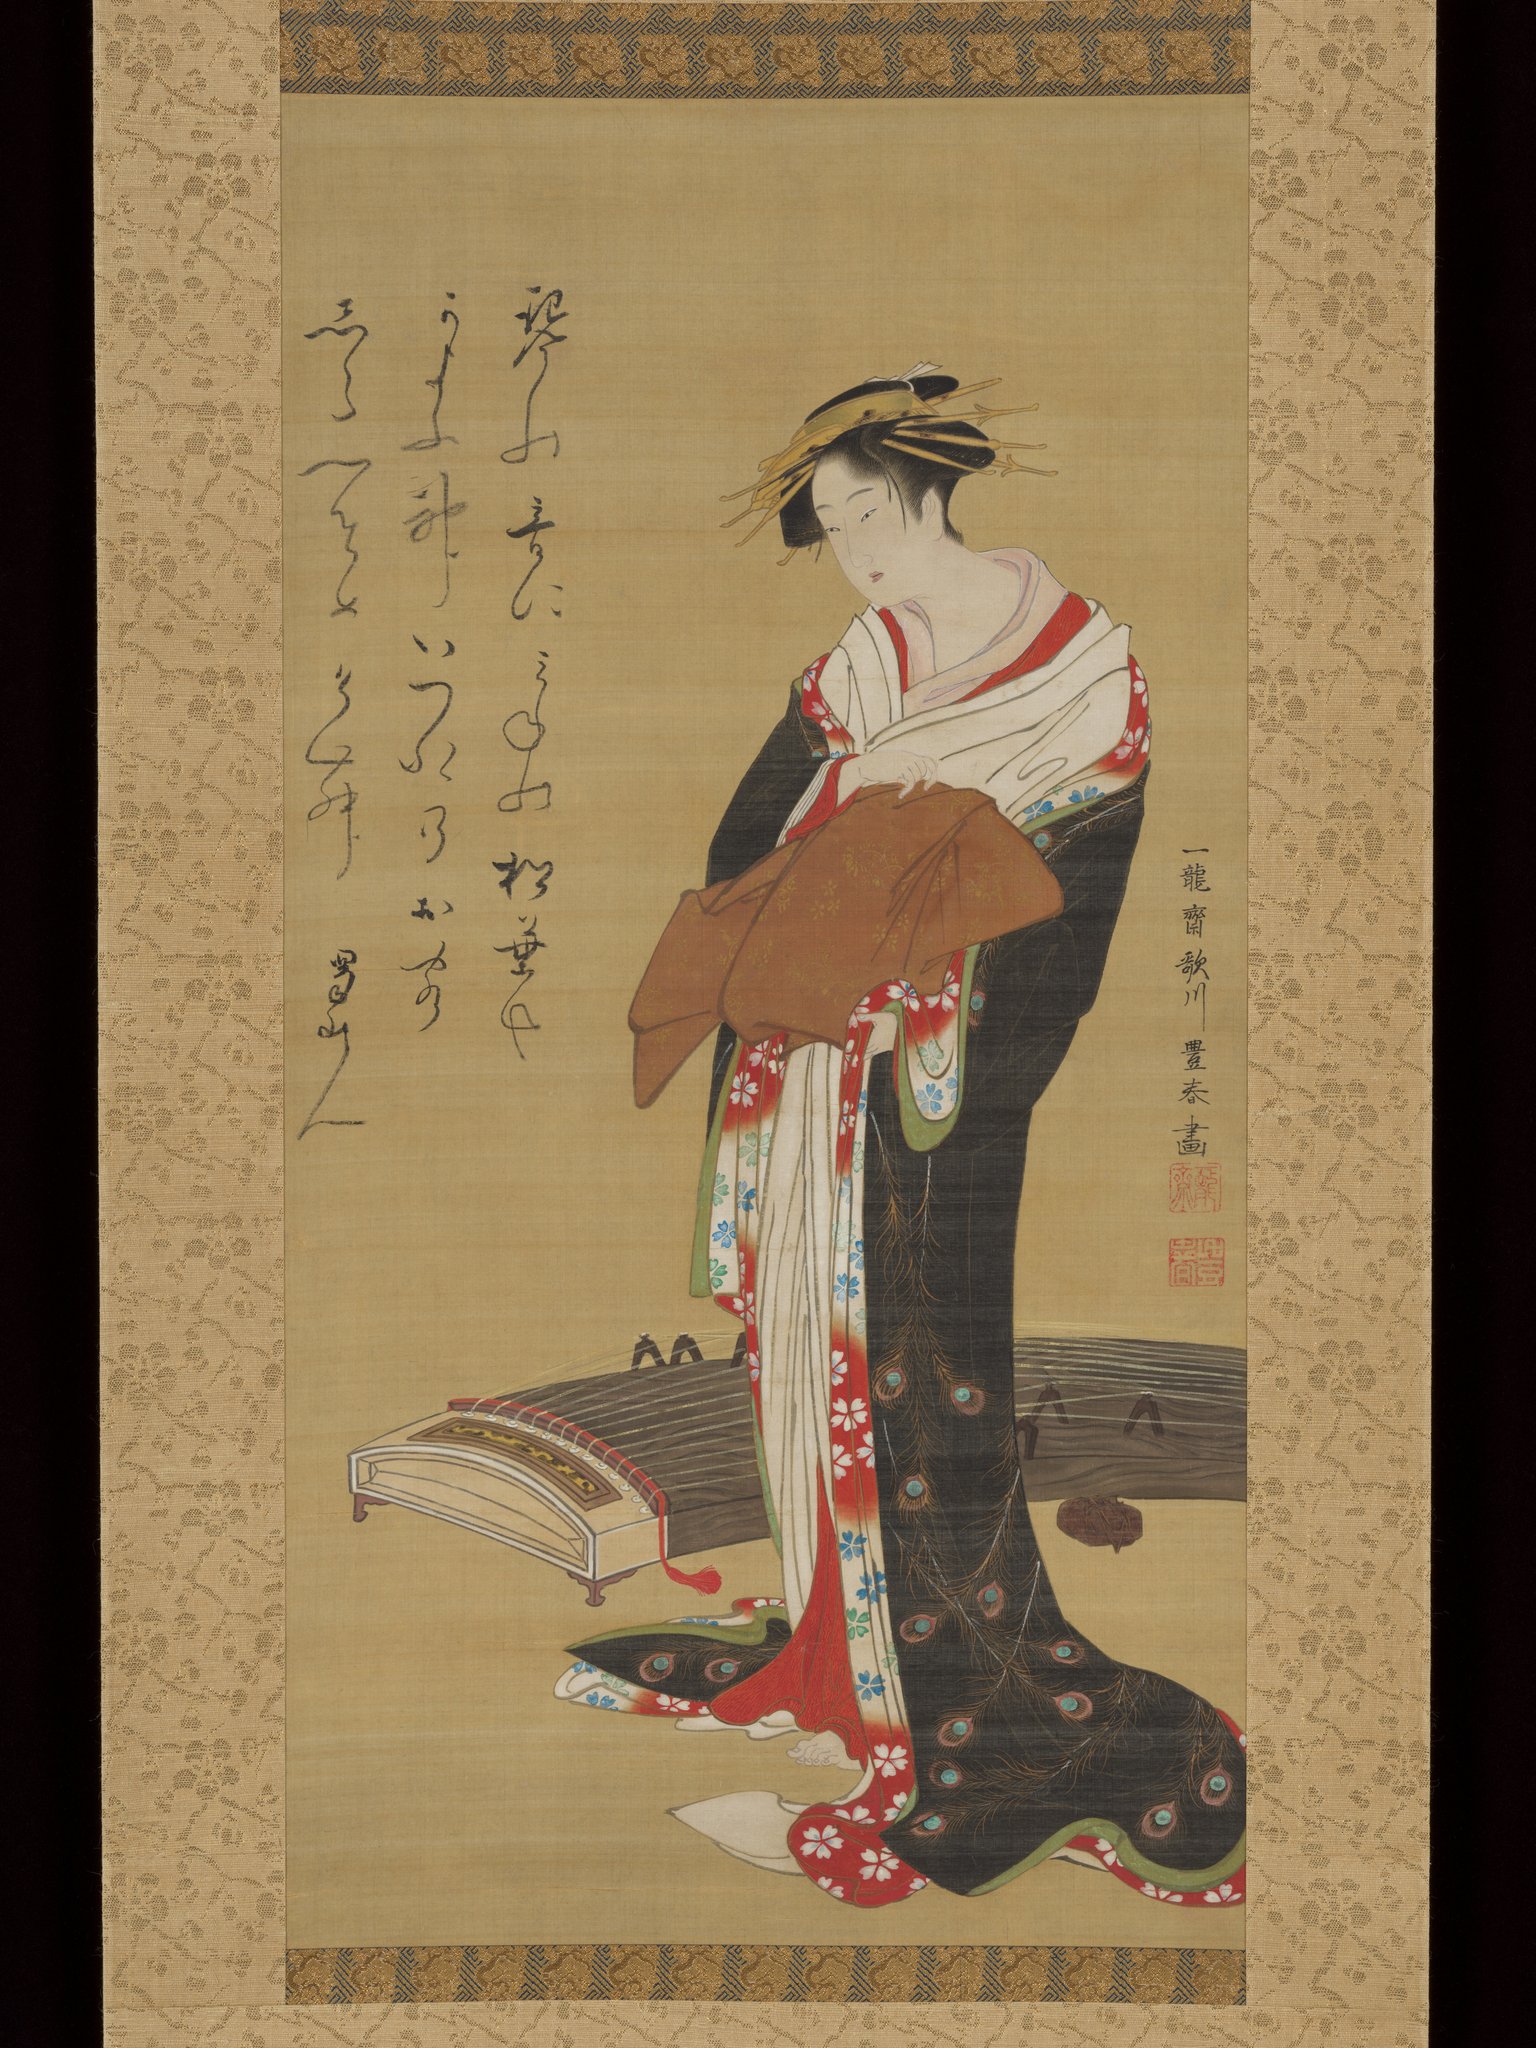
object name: hanging scroll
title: Female Entertainer with a Koto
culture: japanese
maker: utagawa toyoharu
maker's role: artist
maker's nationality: japanese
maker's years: 1735-1814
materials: ink, silk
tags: musical instruments,women